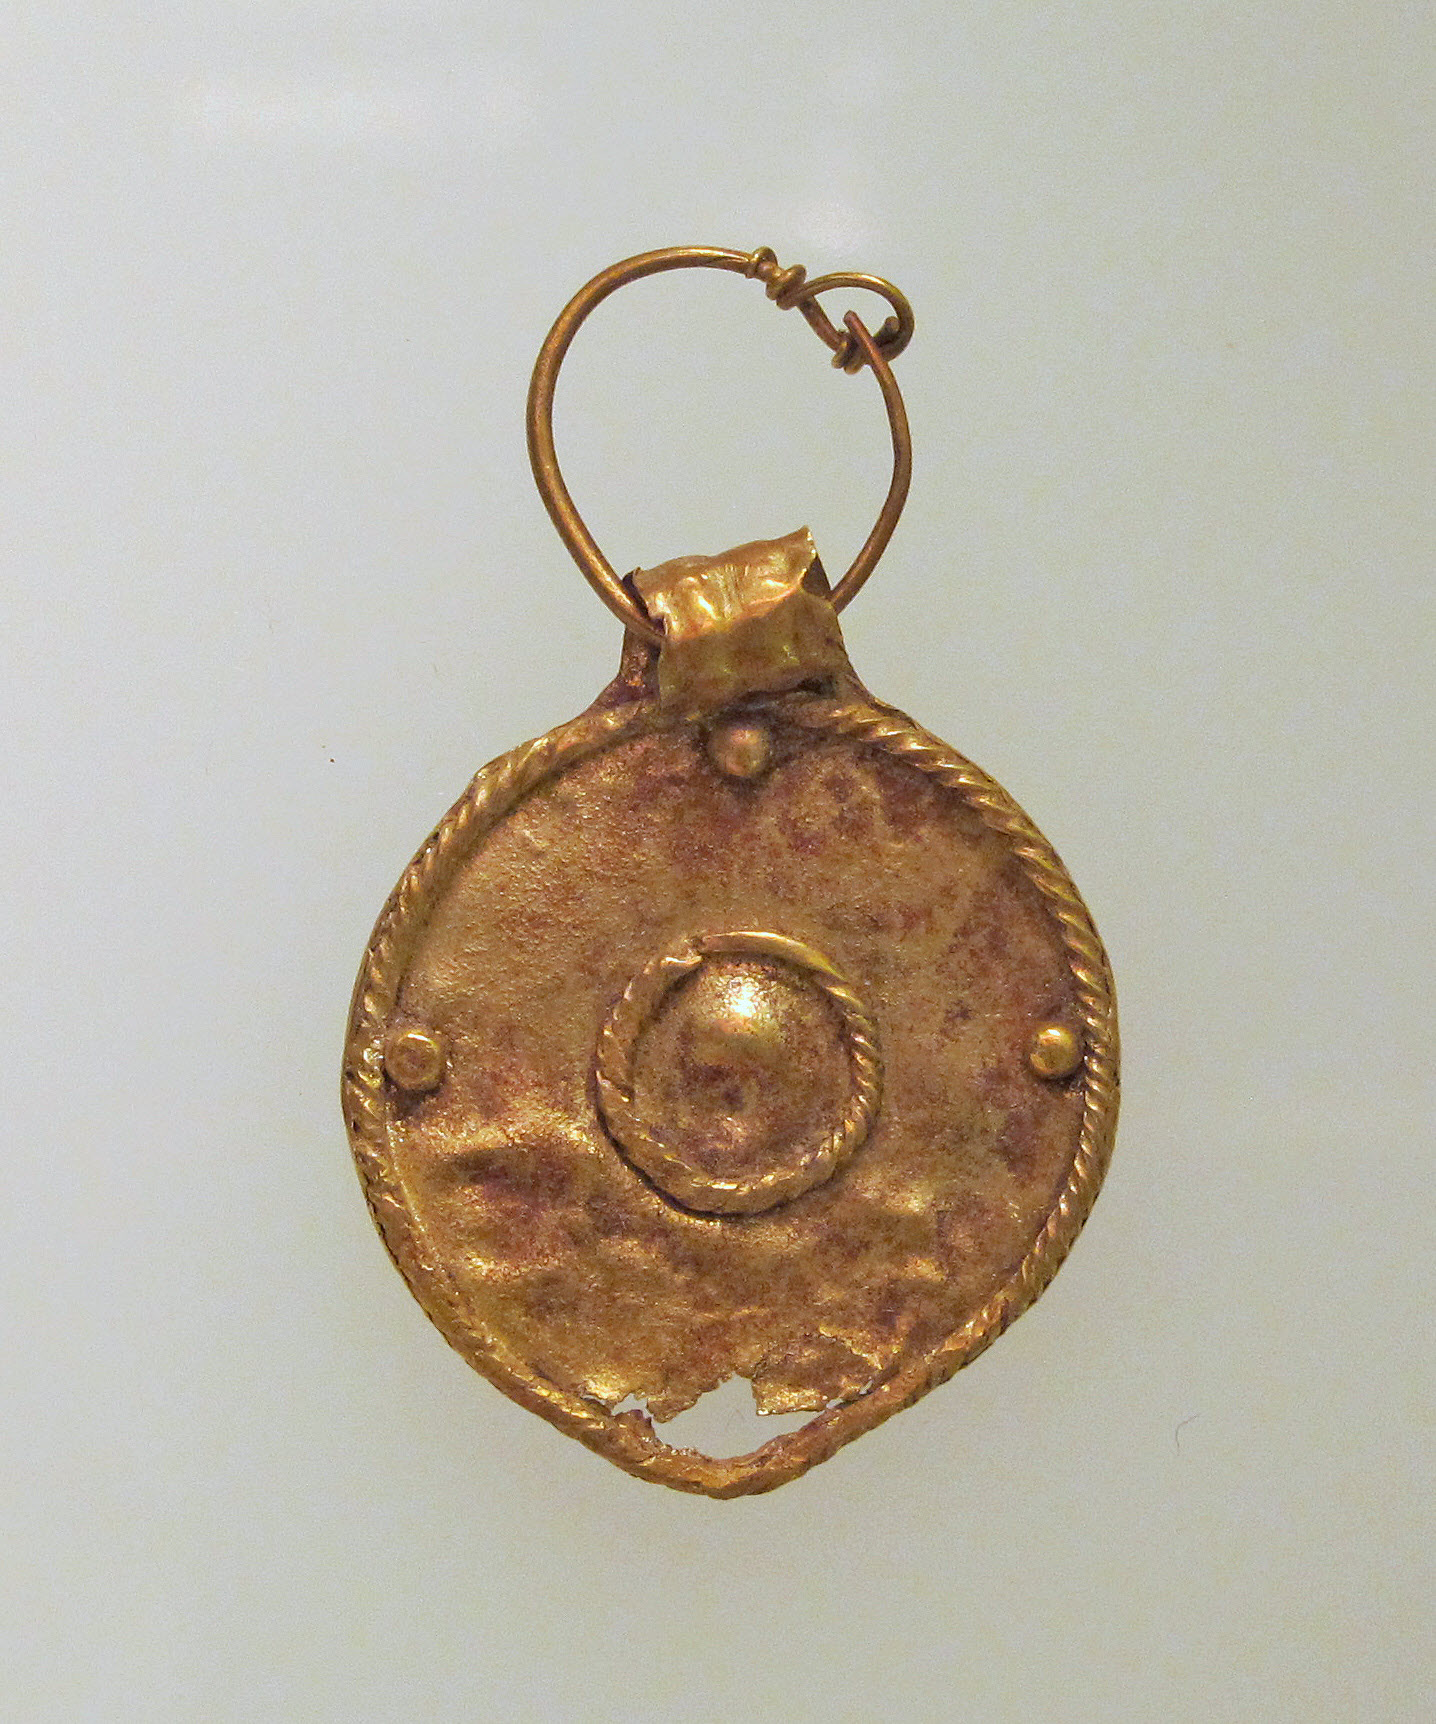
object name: pendant disk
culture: cypriot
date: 3900 BCE-100 CE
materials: gold